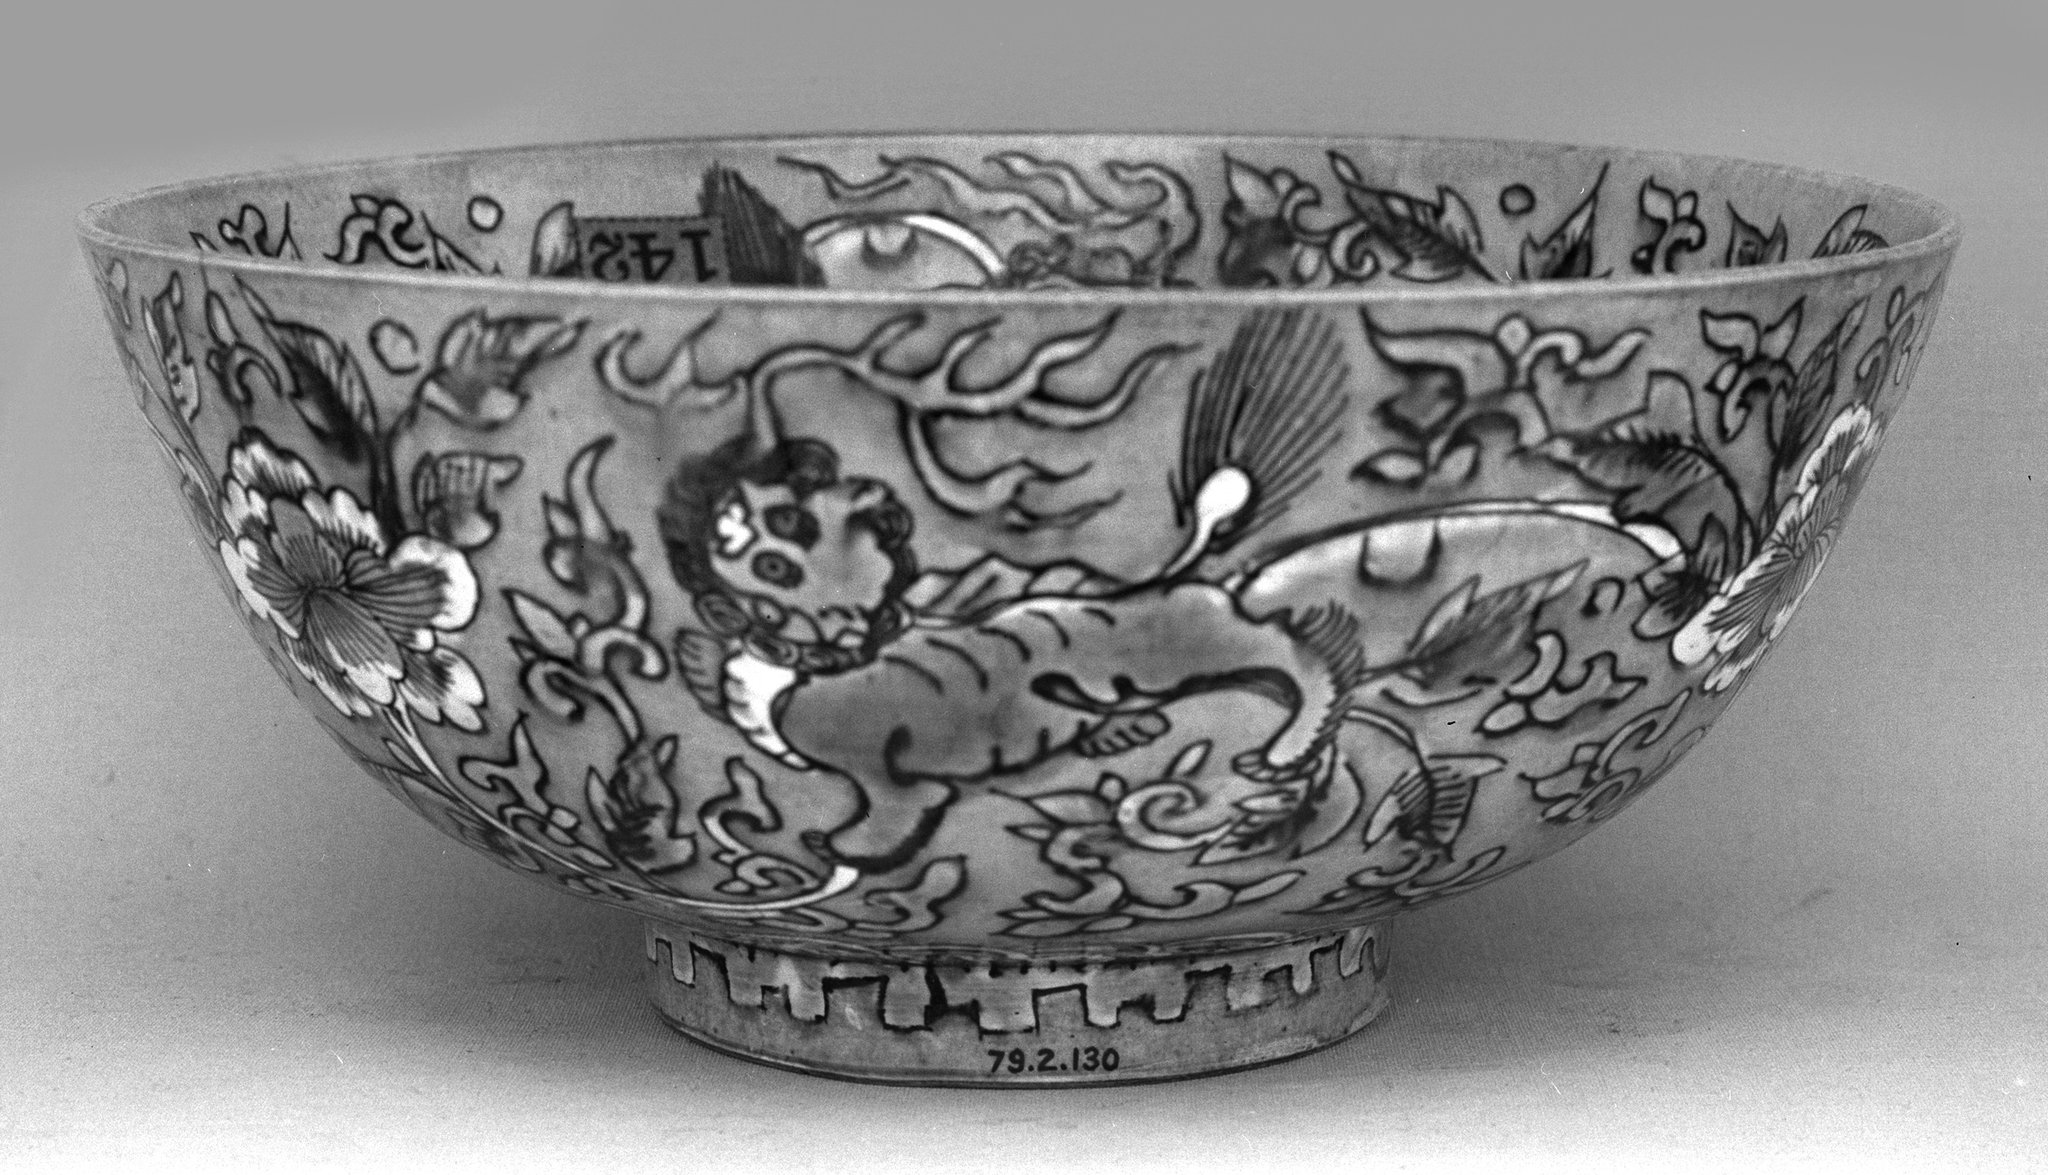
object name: bowl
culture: chinese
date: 1701-1800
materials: biscuit, enamel, porcelain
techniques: painting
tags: mythical creatures,flowers